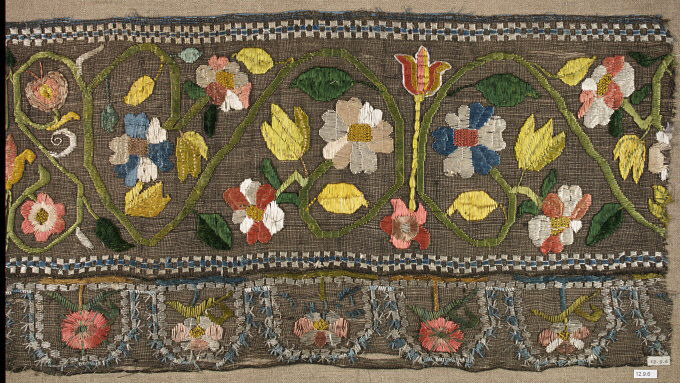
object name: strip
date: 1701-1800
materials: silk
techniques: embroidery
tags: flowers,leaves